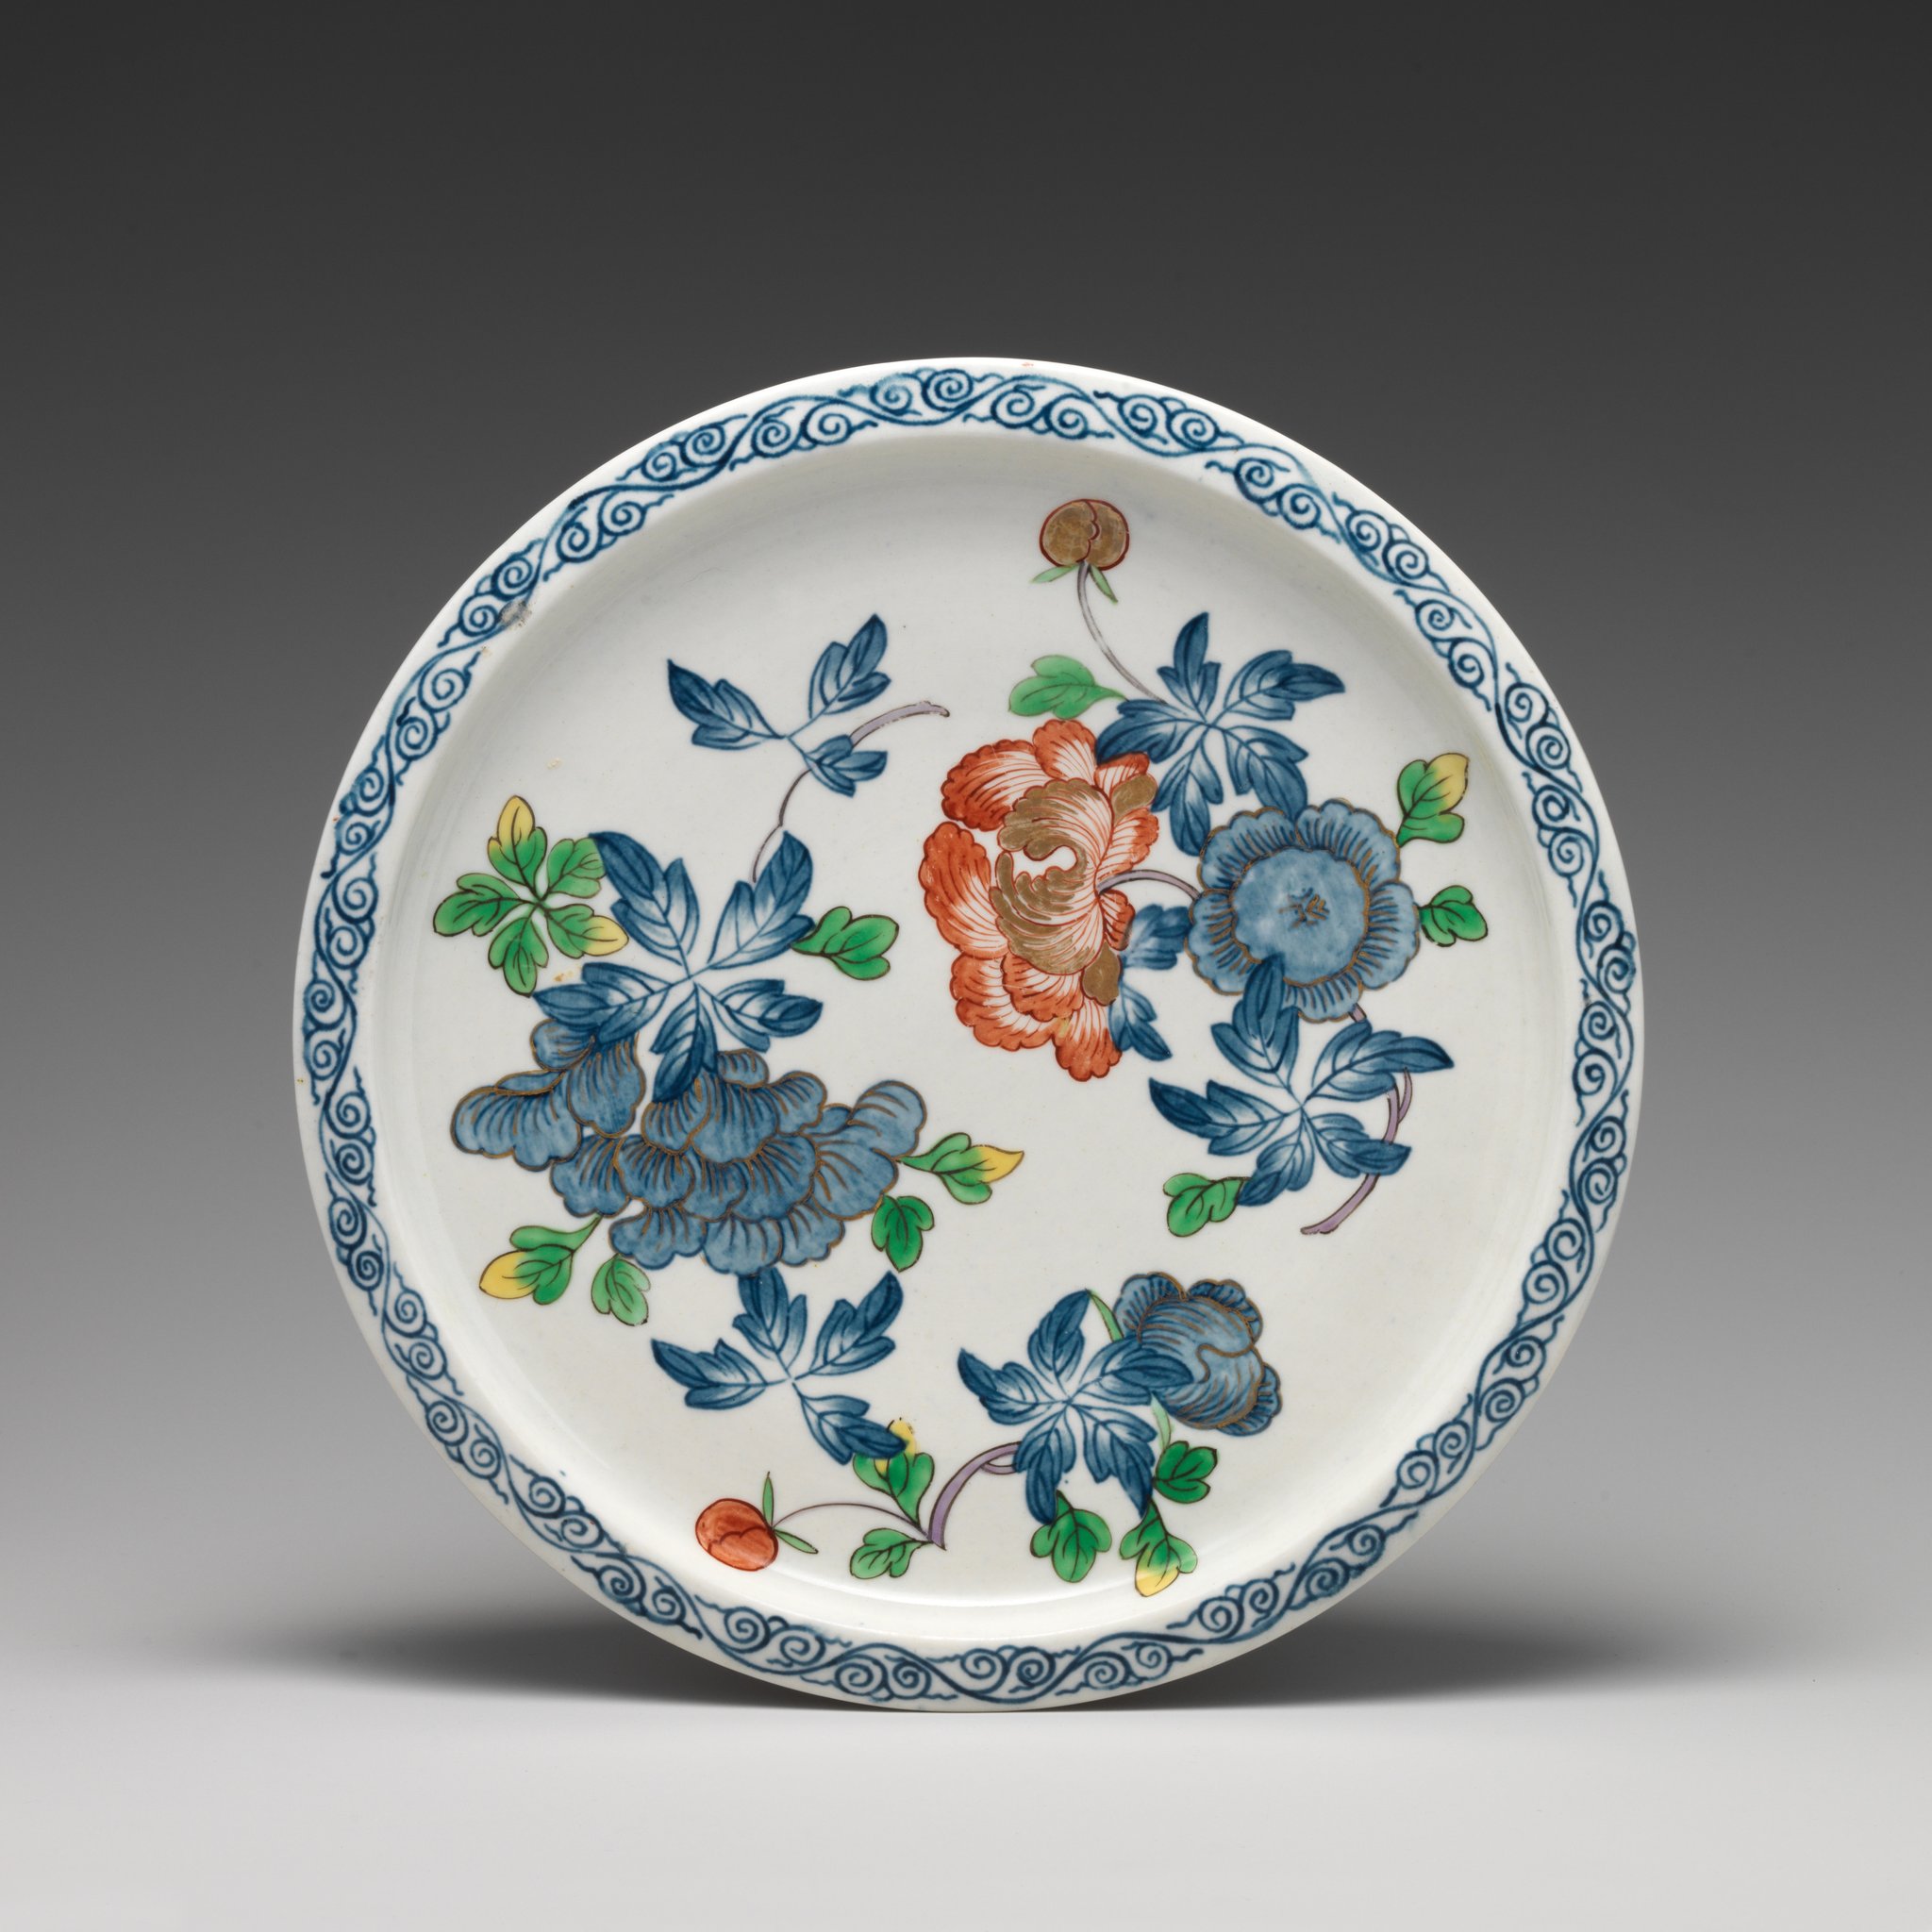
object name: plate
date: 1770-1772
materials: soft paste porcelain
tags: flowers